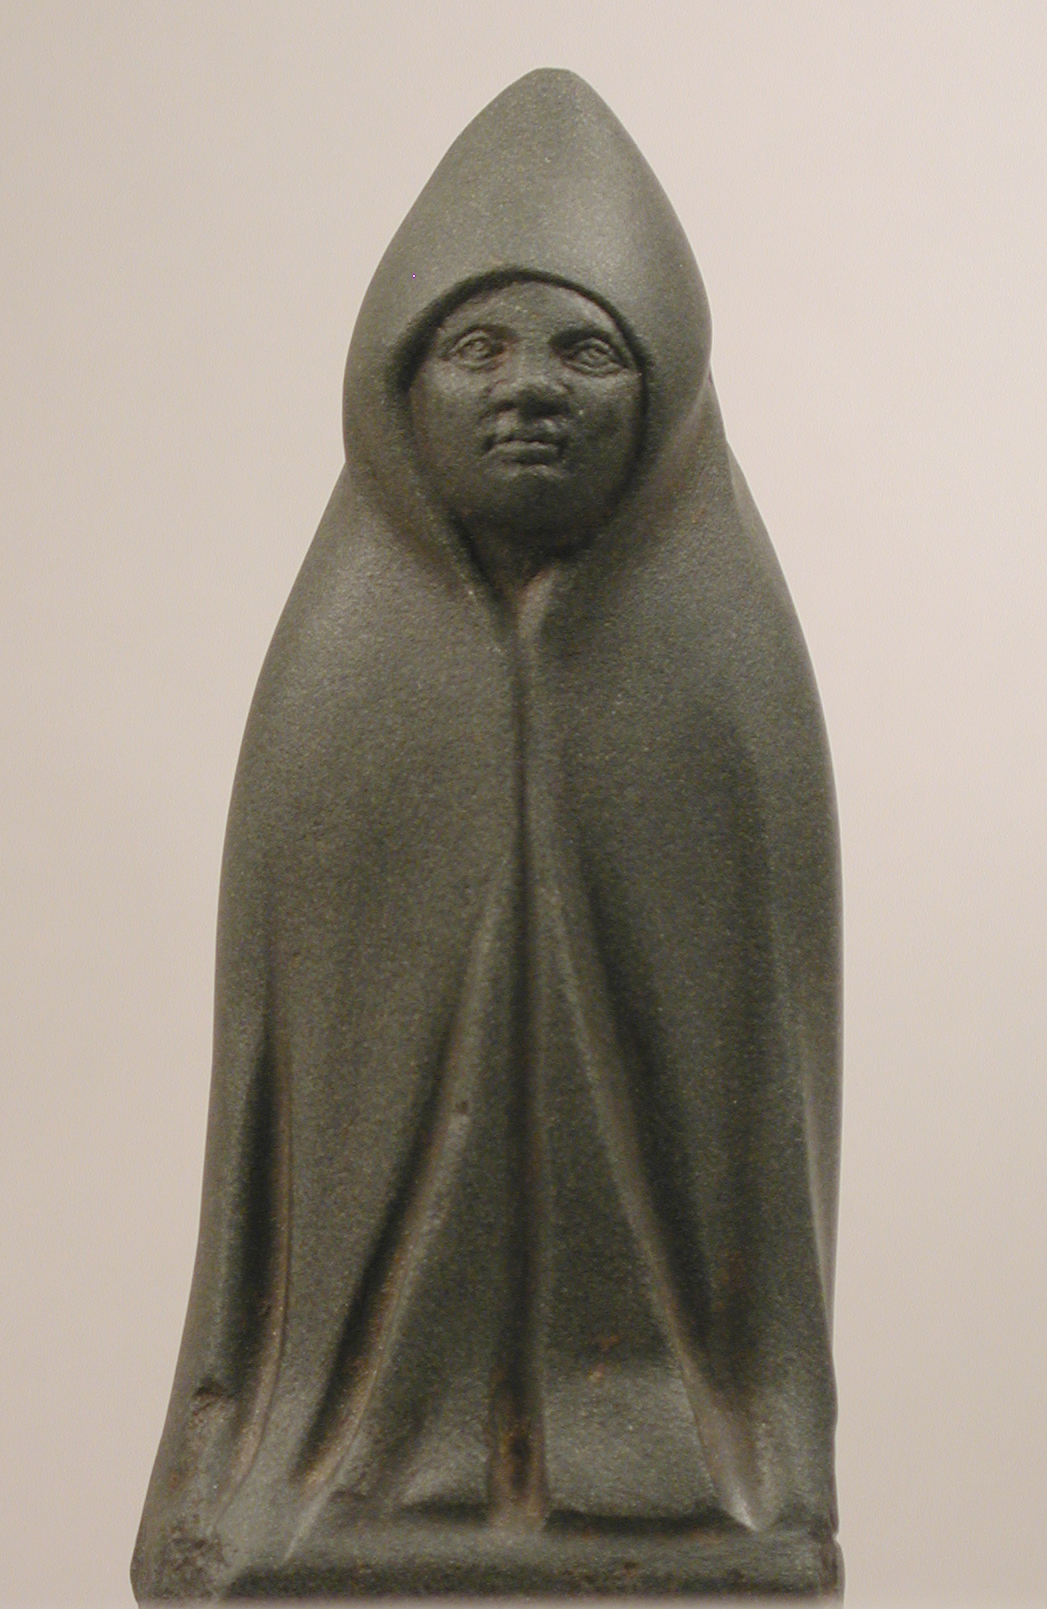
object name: statuette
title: Statuette, Hooded Figure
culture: celtic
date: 1-300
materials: stone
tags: human figures